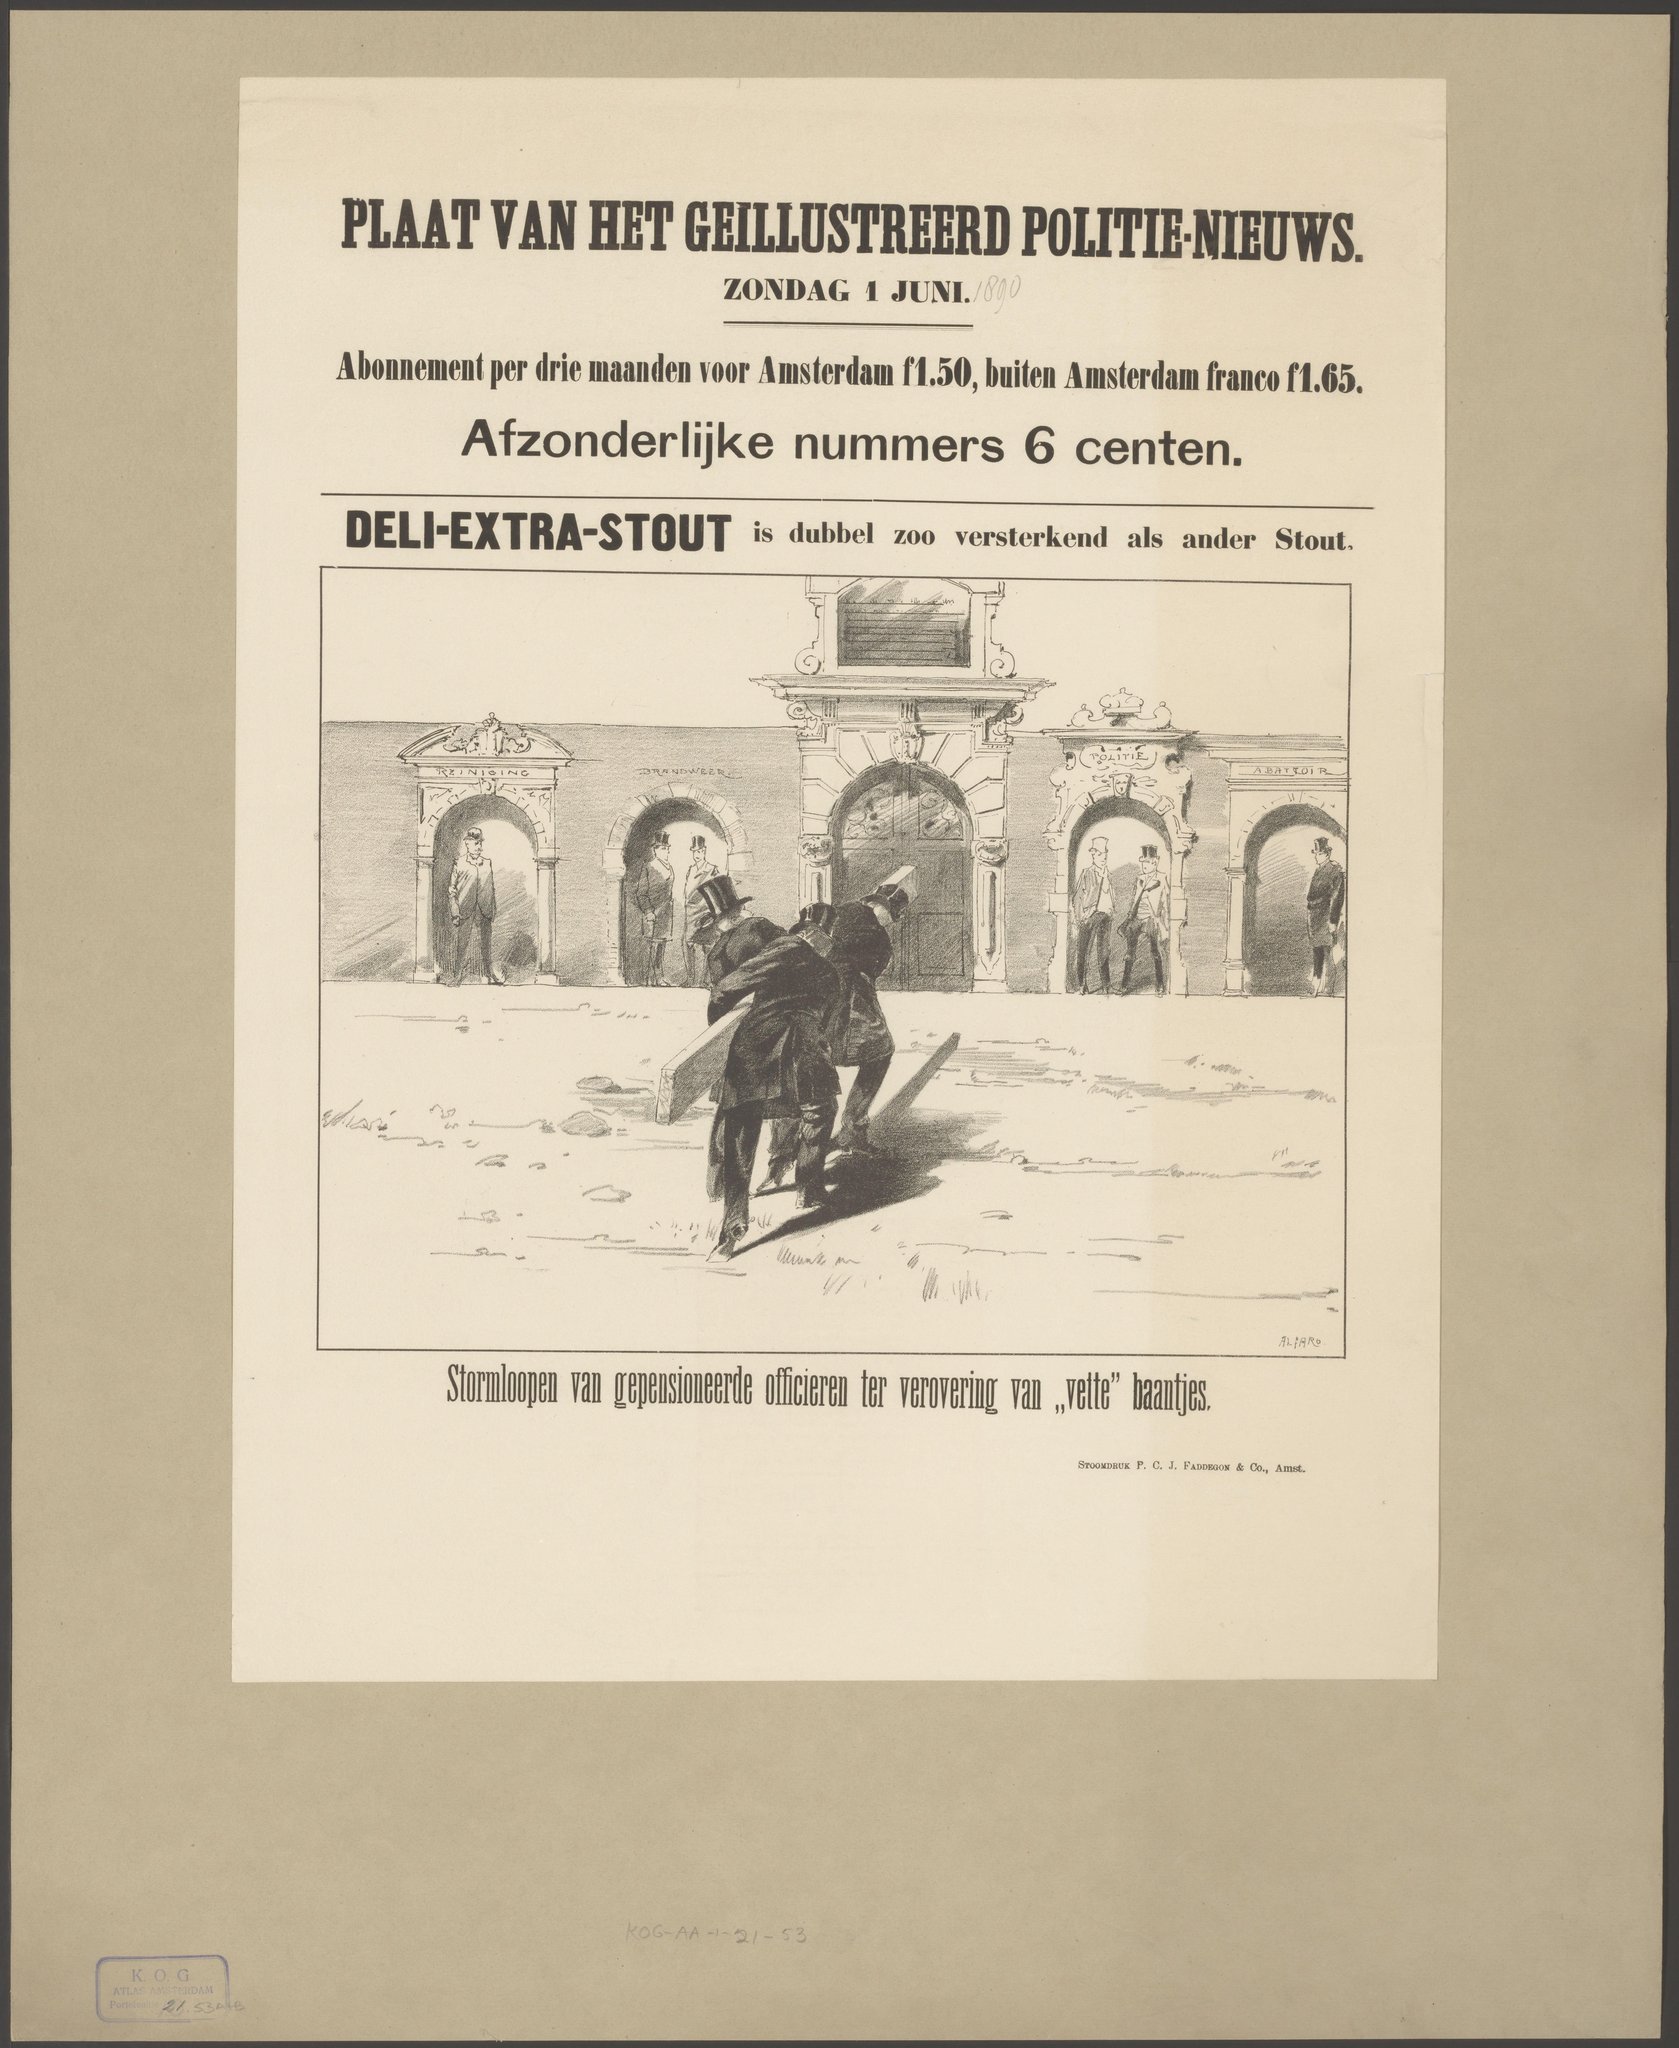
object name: newspaper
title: Drie mannen met stormram lopen op een poort af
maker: alfaro reijding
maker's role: draughtsman, engineer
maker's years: 1863-1930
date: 1890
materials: paper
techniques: letterpress printing, lithograph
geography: amsterdam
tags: breaking into city or fortress ~ siege, political caricatures and satires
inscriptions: collector's mark: ‘21-53A+B’ Lugt 1641b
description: Onderwerpsrubriek binnen de Atlas Amsterdam: Herinneringen aan ambtenaren.